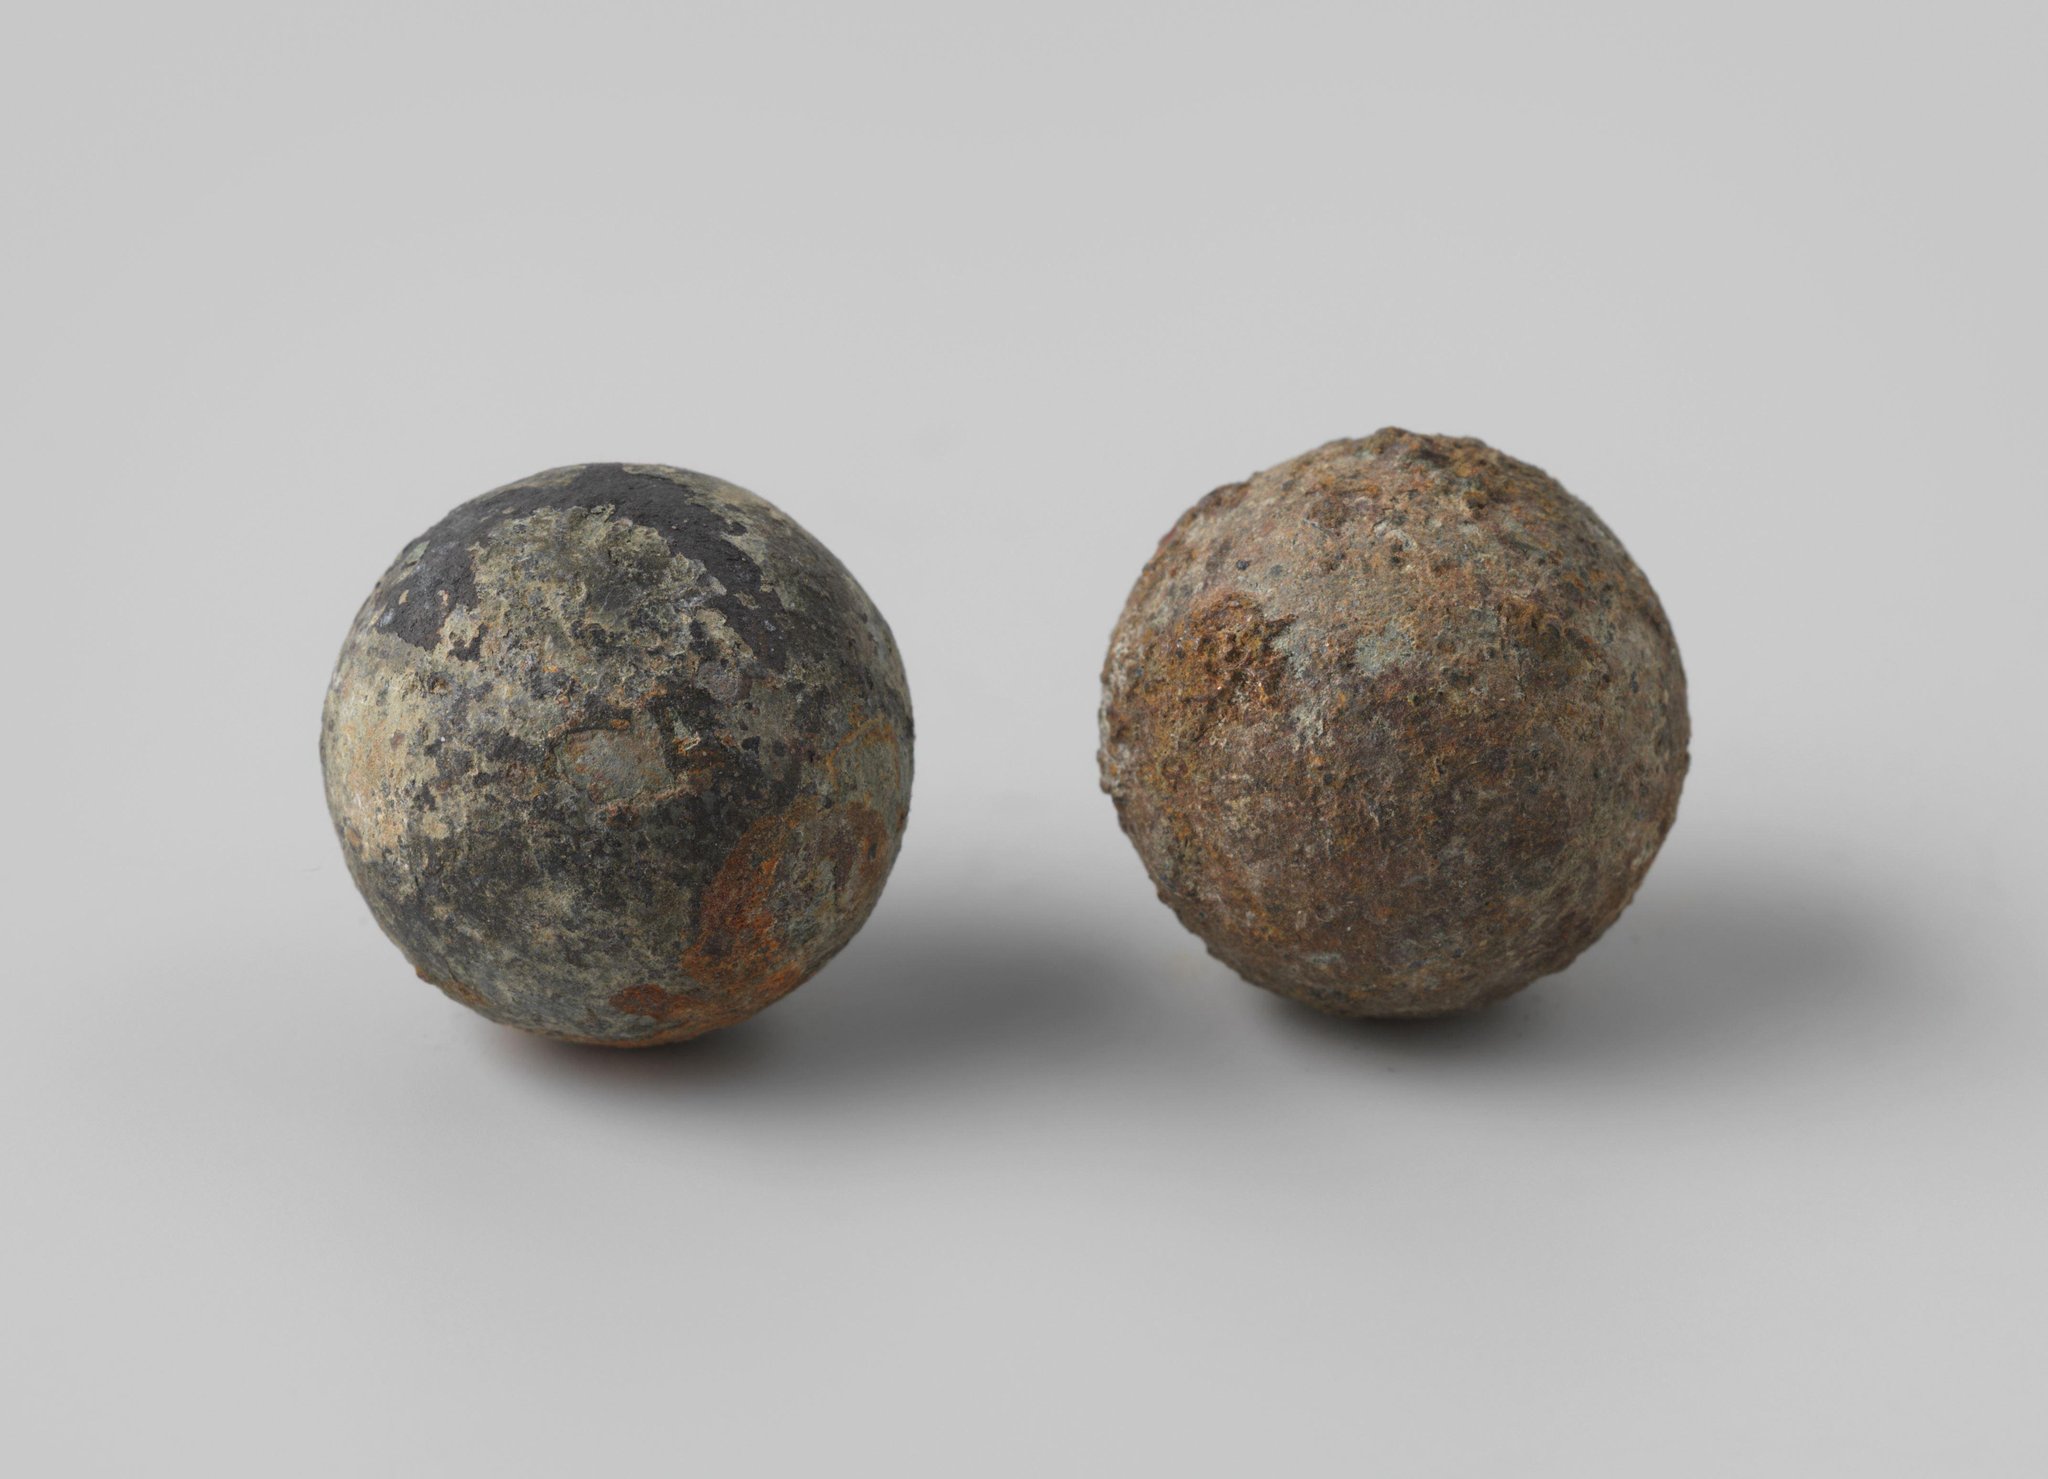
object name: musketkogel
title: Musketkogels uit het wrak van de Oost-Indiëvaarder Hollandia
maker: Anonymous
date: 1700-1743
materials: lead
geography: netherlands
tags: verenigde oostindische compagnie, hollandia (schip), annet